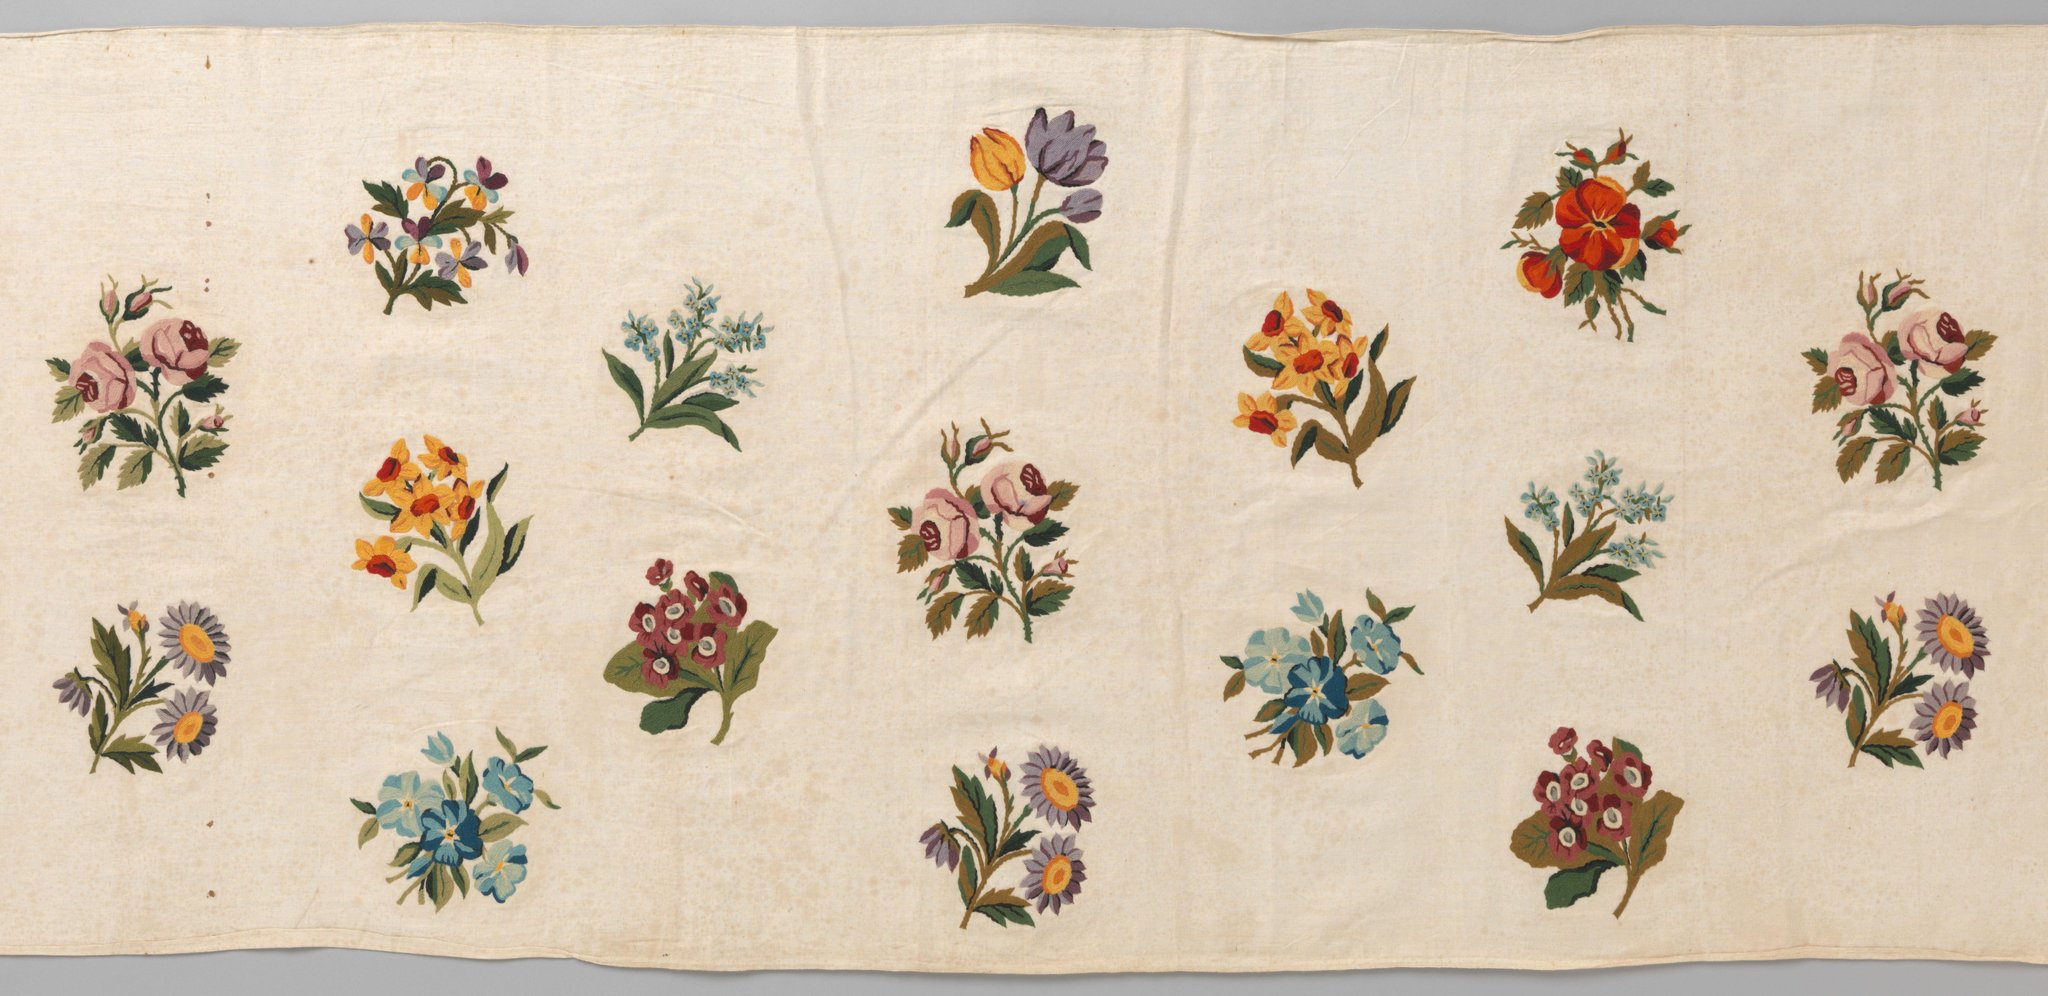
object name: bekledingsstof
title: Metrage bekledingsstof met borduurwerk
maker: Anonymous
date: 1850-1949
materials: cotton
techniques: weave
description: Metrage bekledingsstof, geborduurd met kleurige bloemtakken.